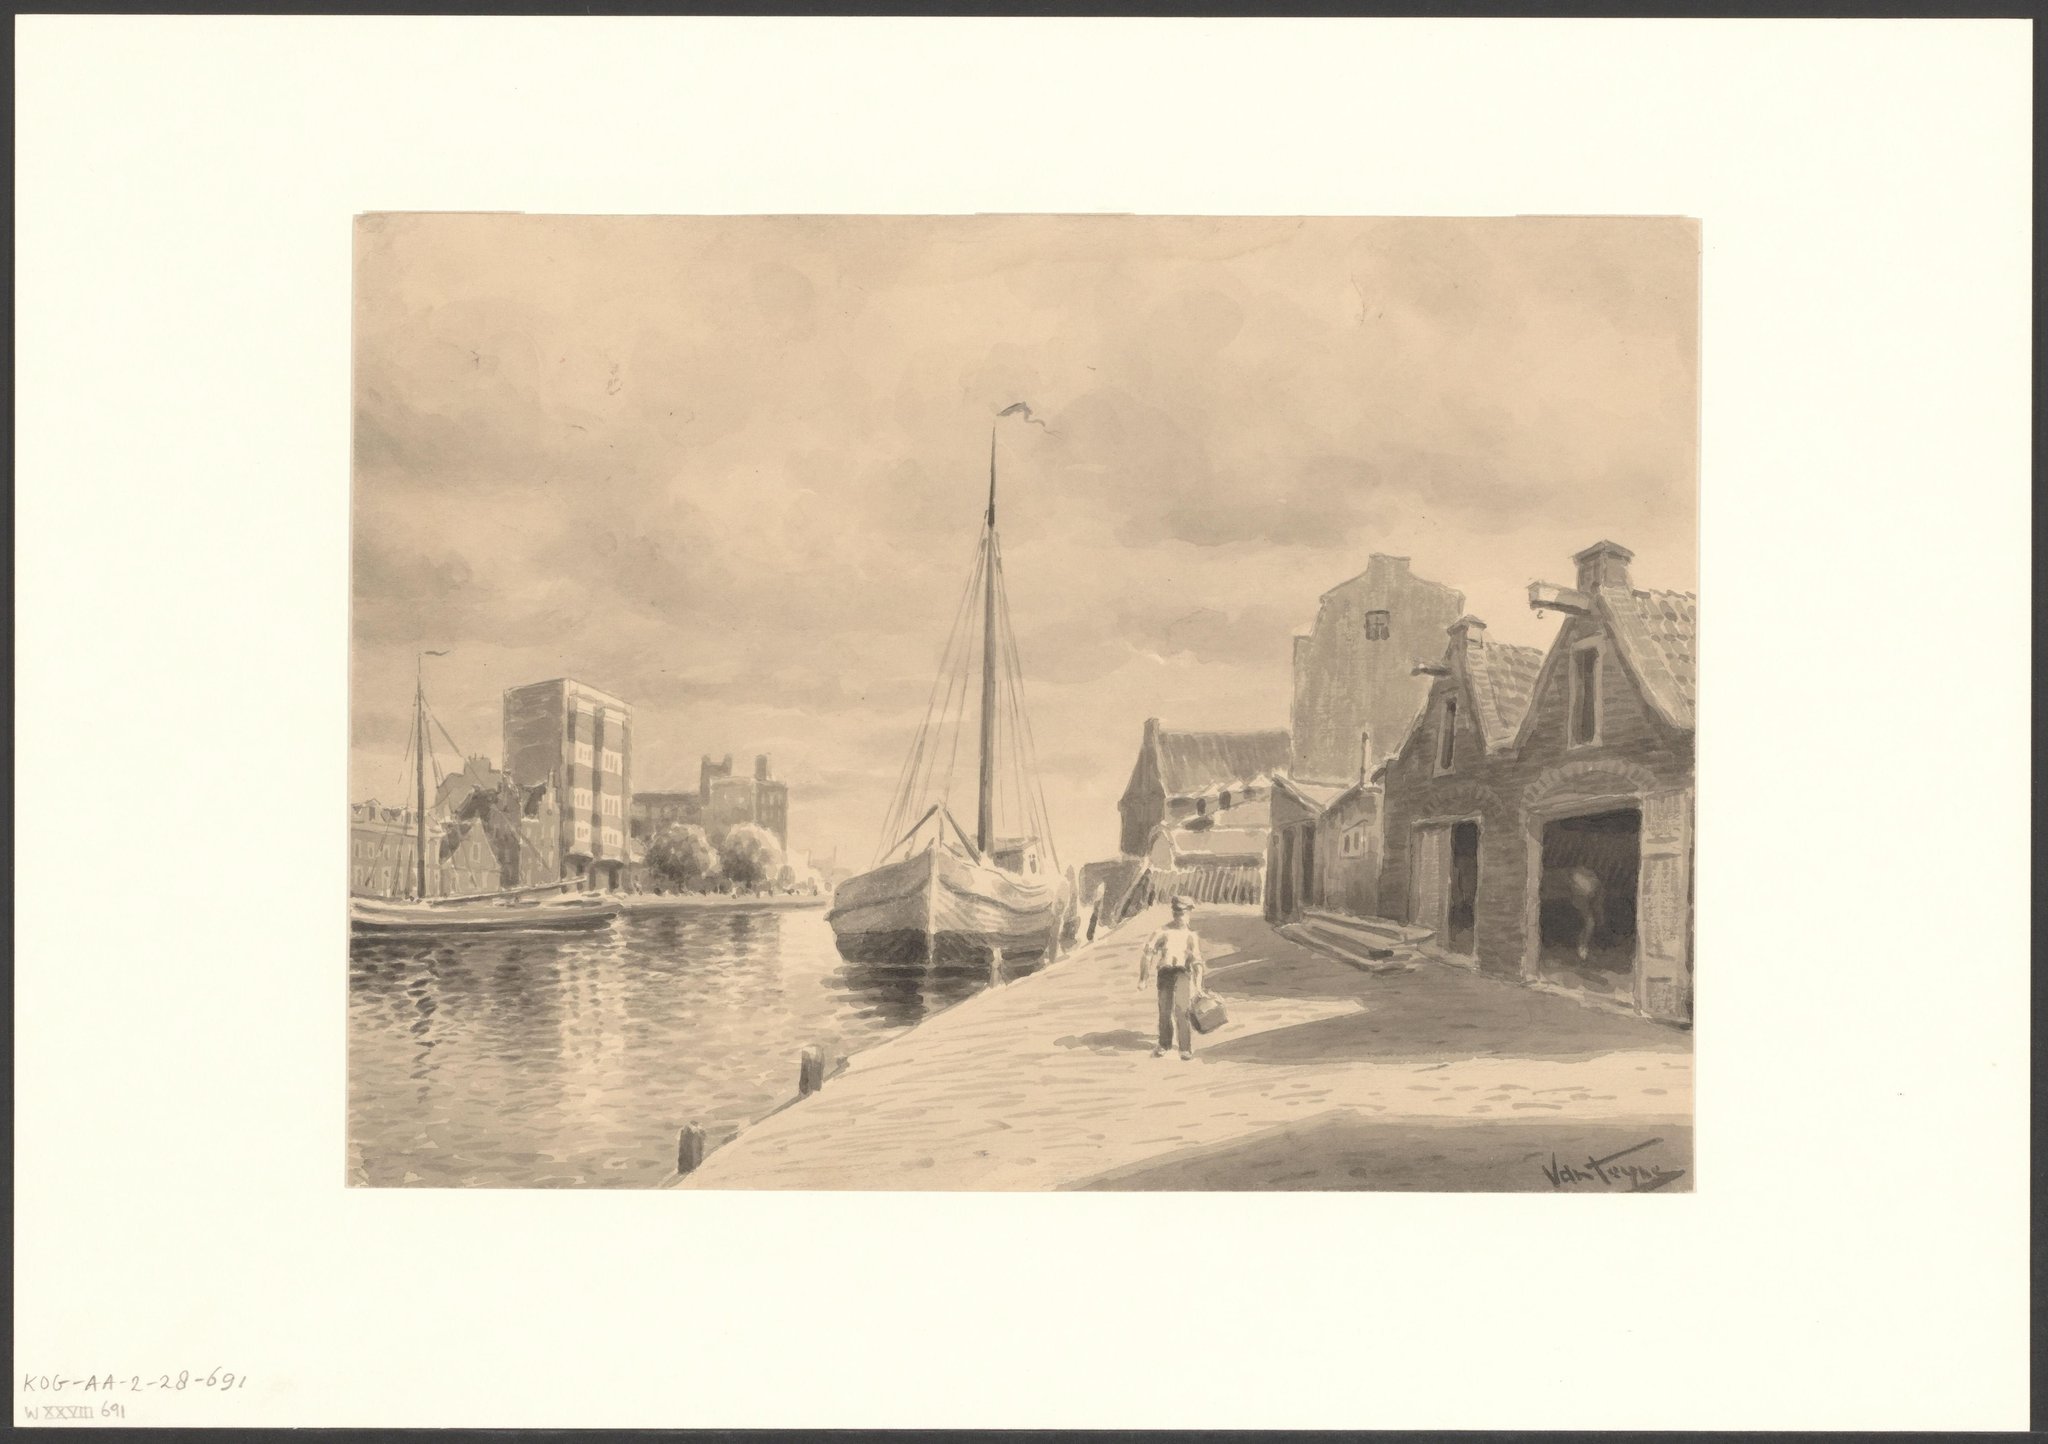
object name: drawing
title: Gezicht op de Kostverlorenvaart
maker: anthonie van teijn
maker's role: draughtsman, painter, print maker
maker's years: 1863-1943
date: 1907-1927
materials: ink, paper, pencil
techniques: brush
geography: amsterdam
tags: city-view in general; 'veduta', canal, bridge in city across river, canal, etc.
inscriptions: signature: ‘VanTeyne’, collector's mark: Lugt 800a, inscription: ‘De Kost verloren (...) Juli 1927 / vEck’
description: Tekening binnen de Atlas Van Eck ingedeeld op wijknummer 28.